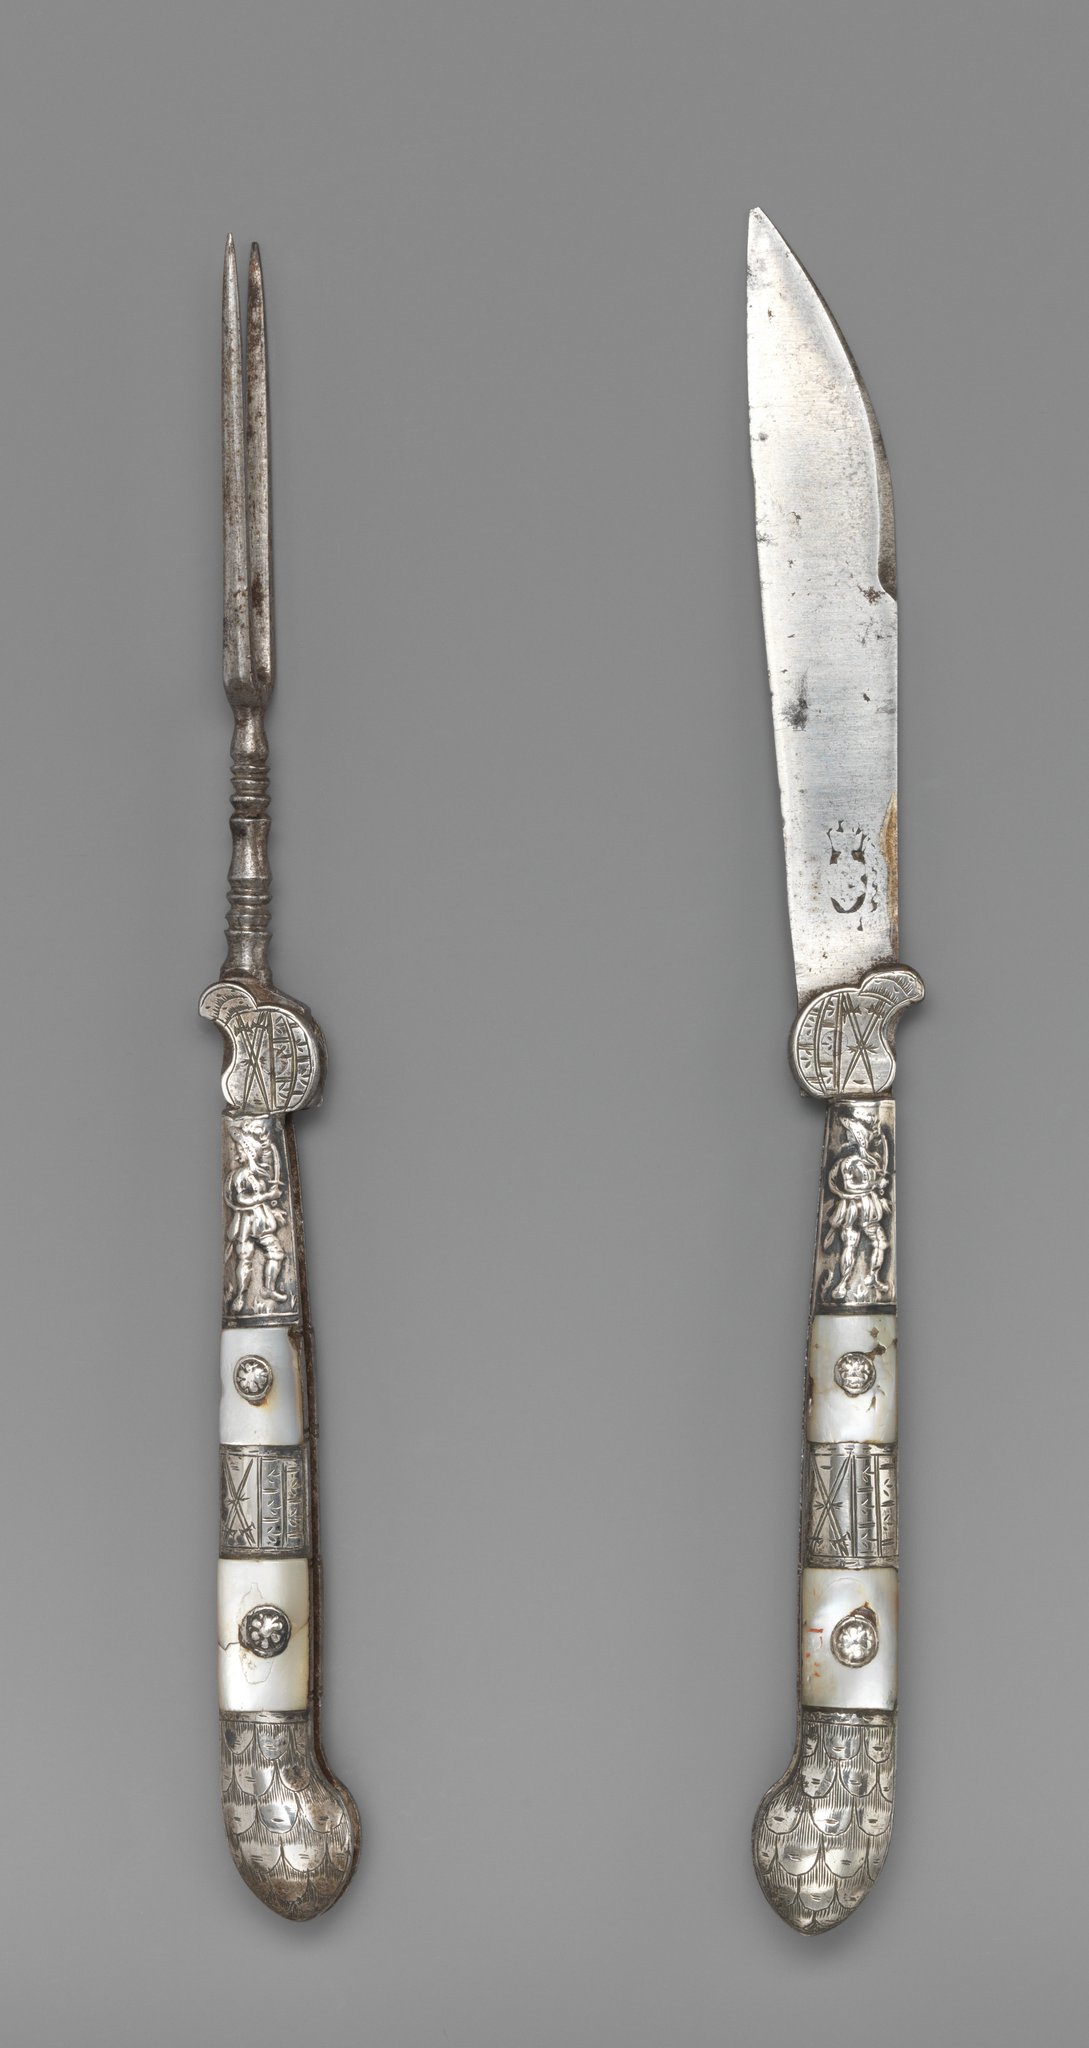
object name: folding knife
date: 1601-1700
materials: mother of pearl, silver, steel